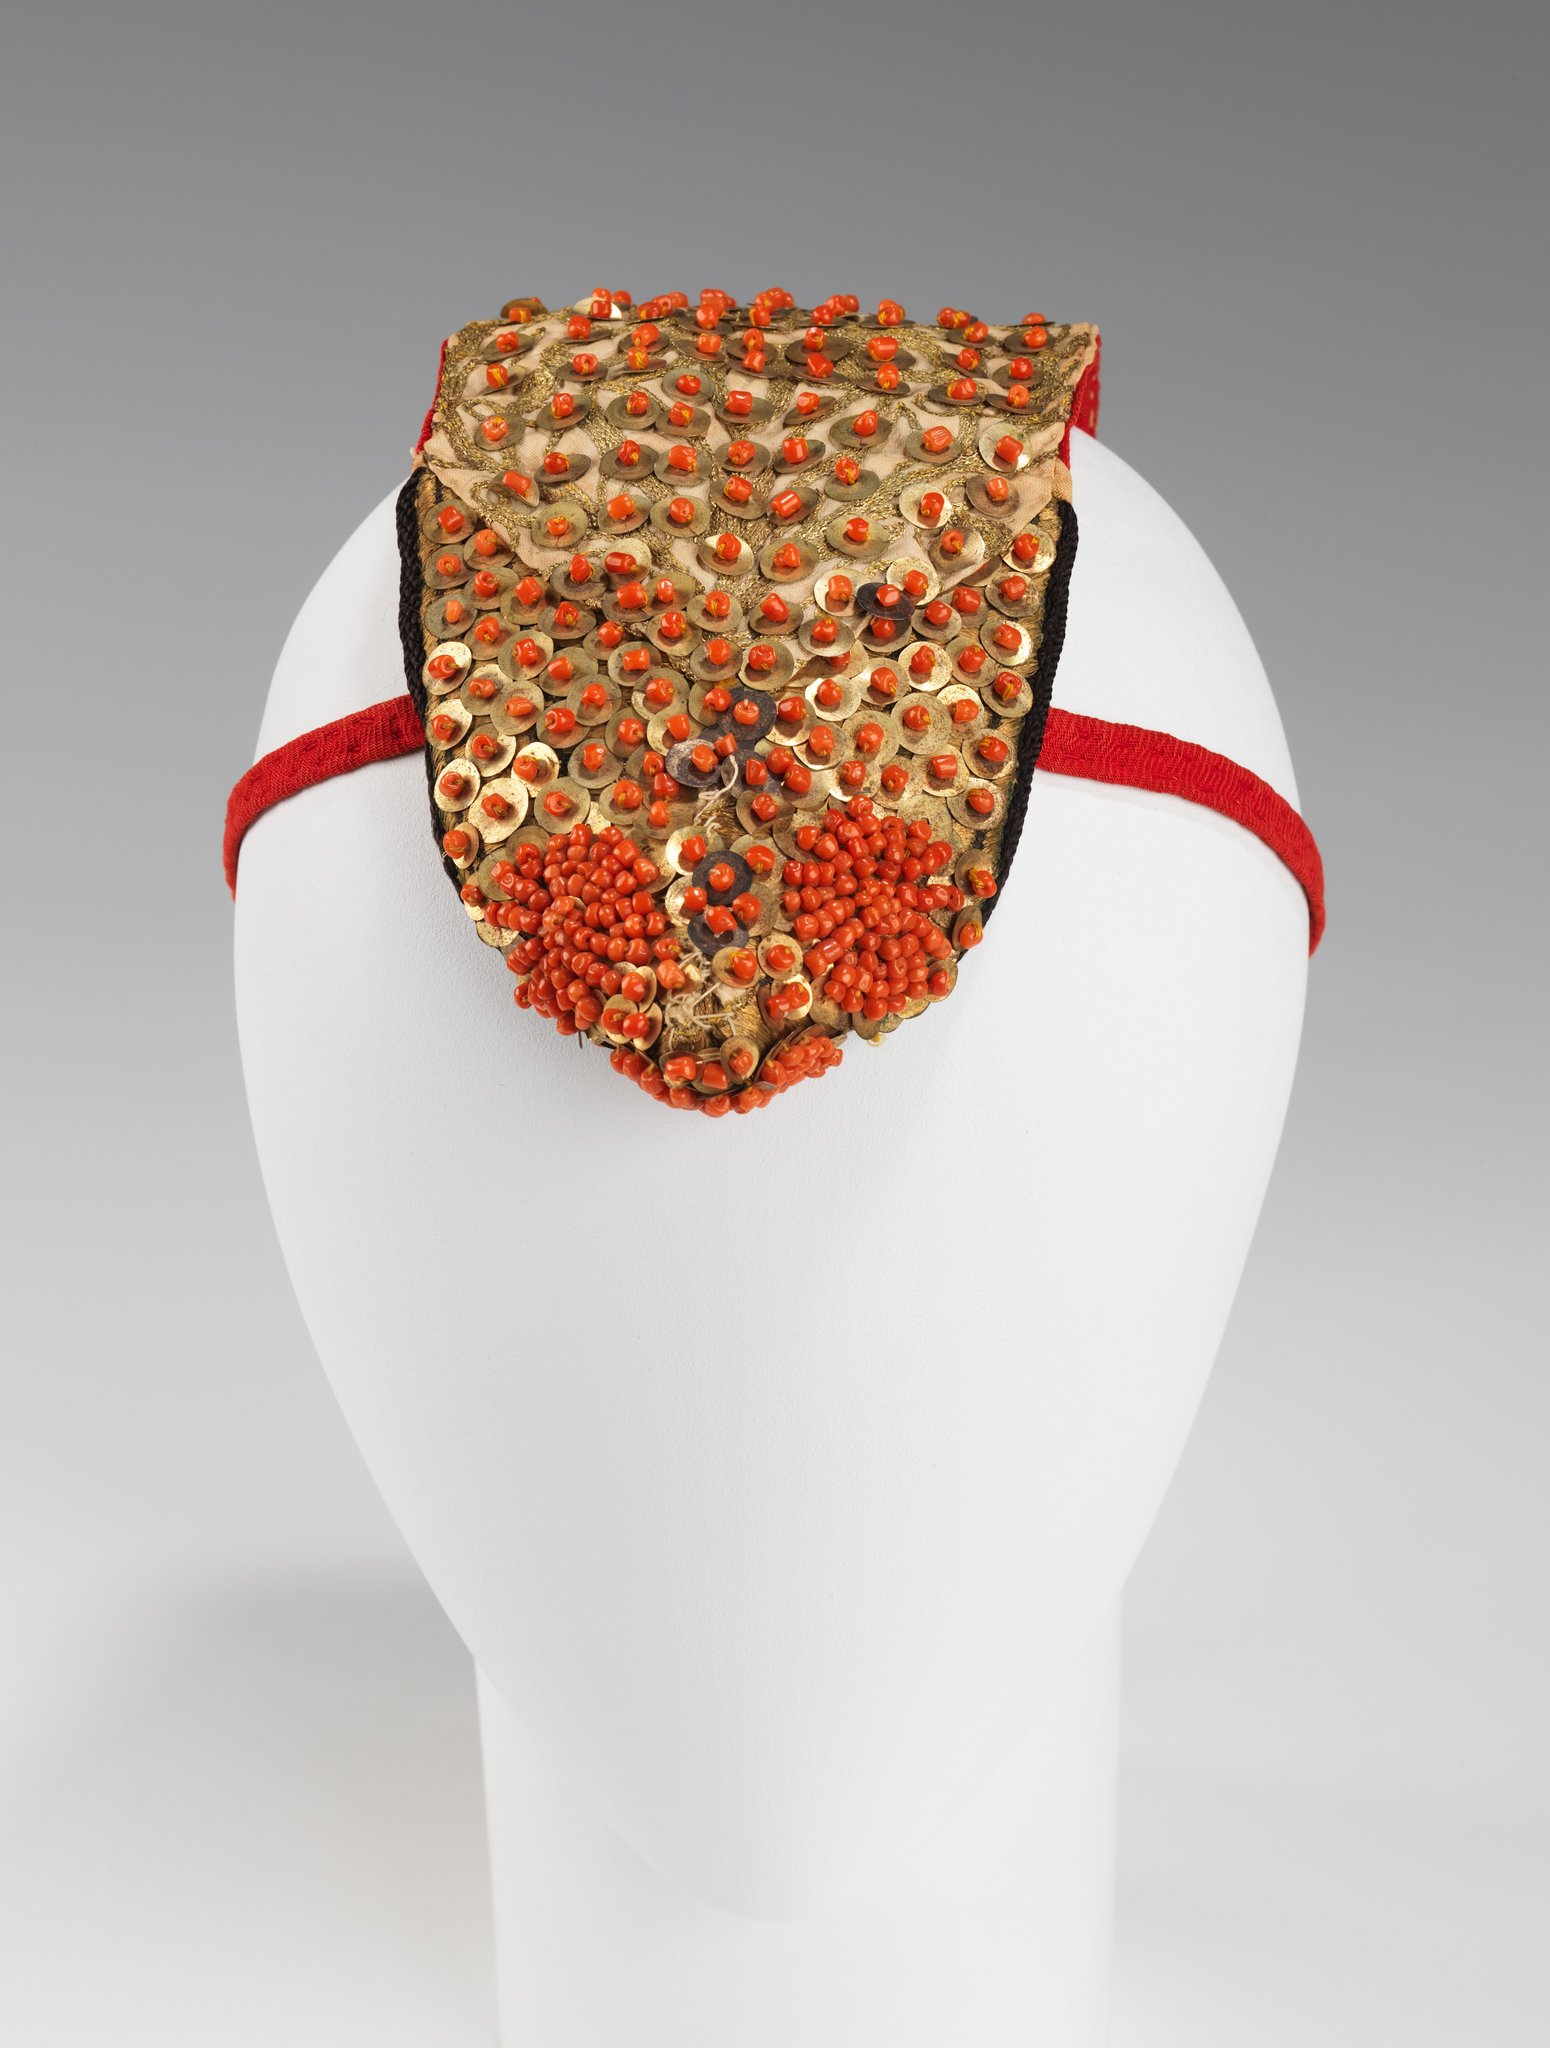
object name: headdress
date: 1867-1900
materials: coral, cotton, metal